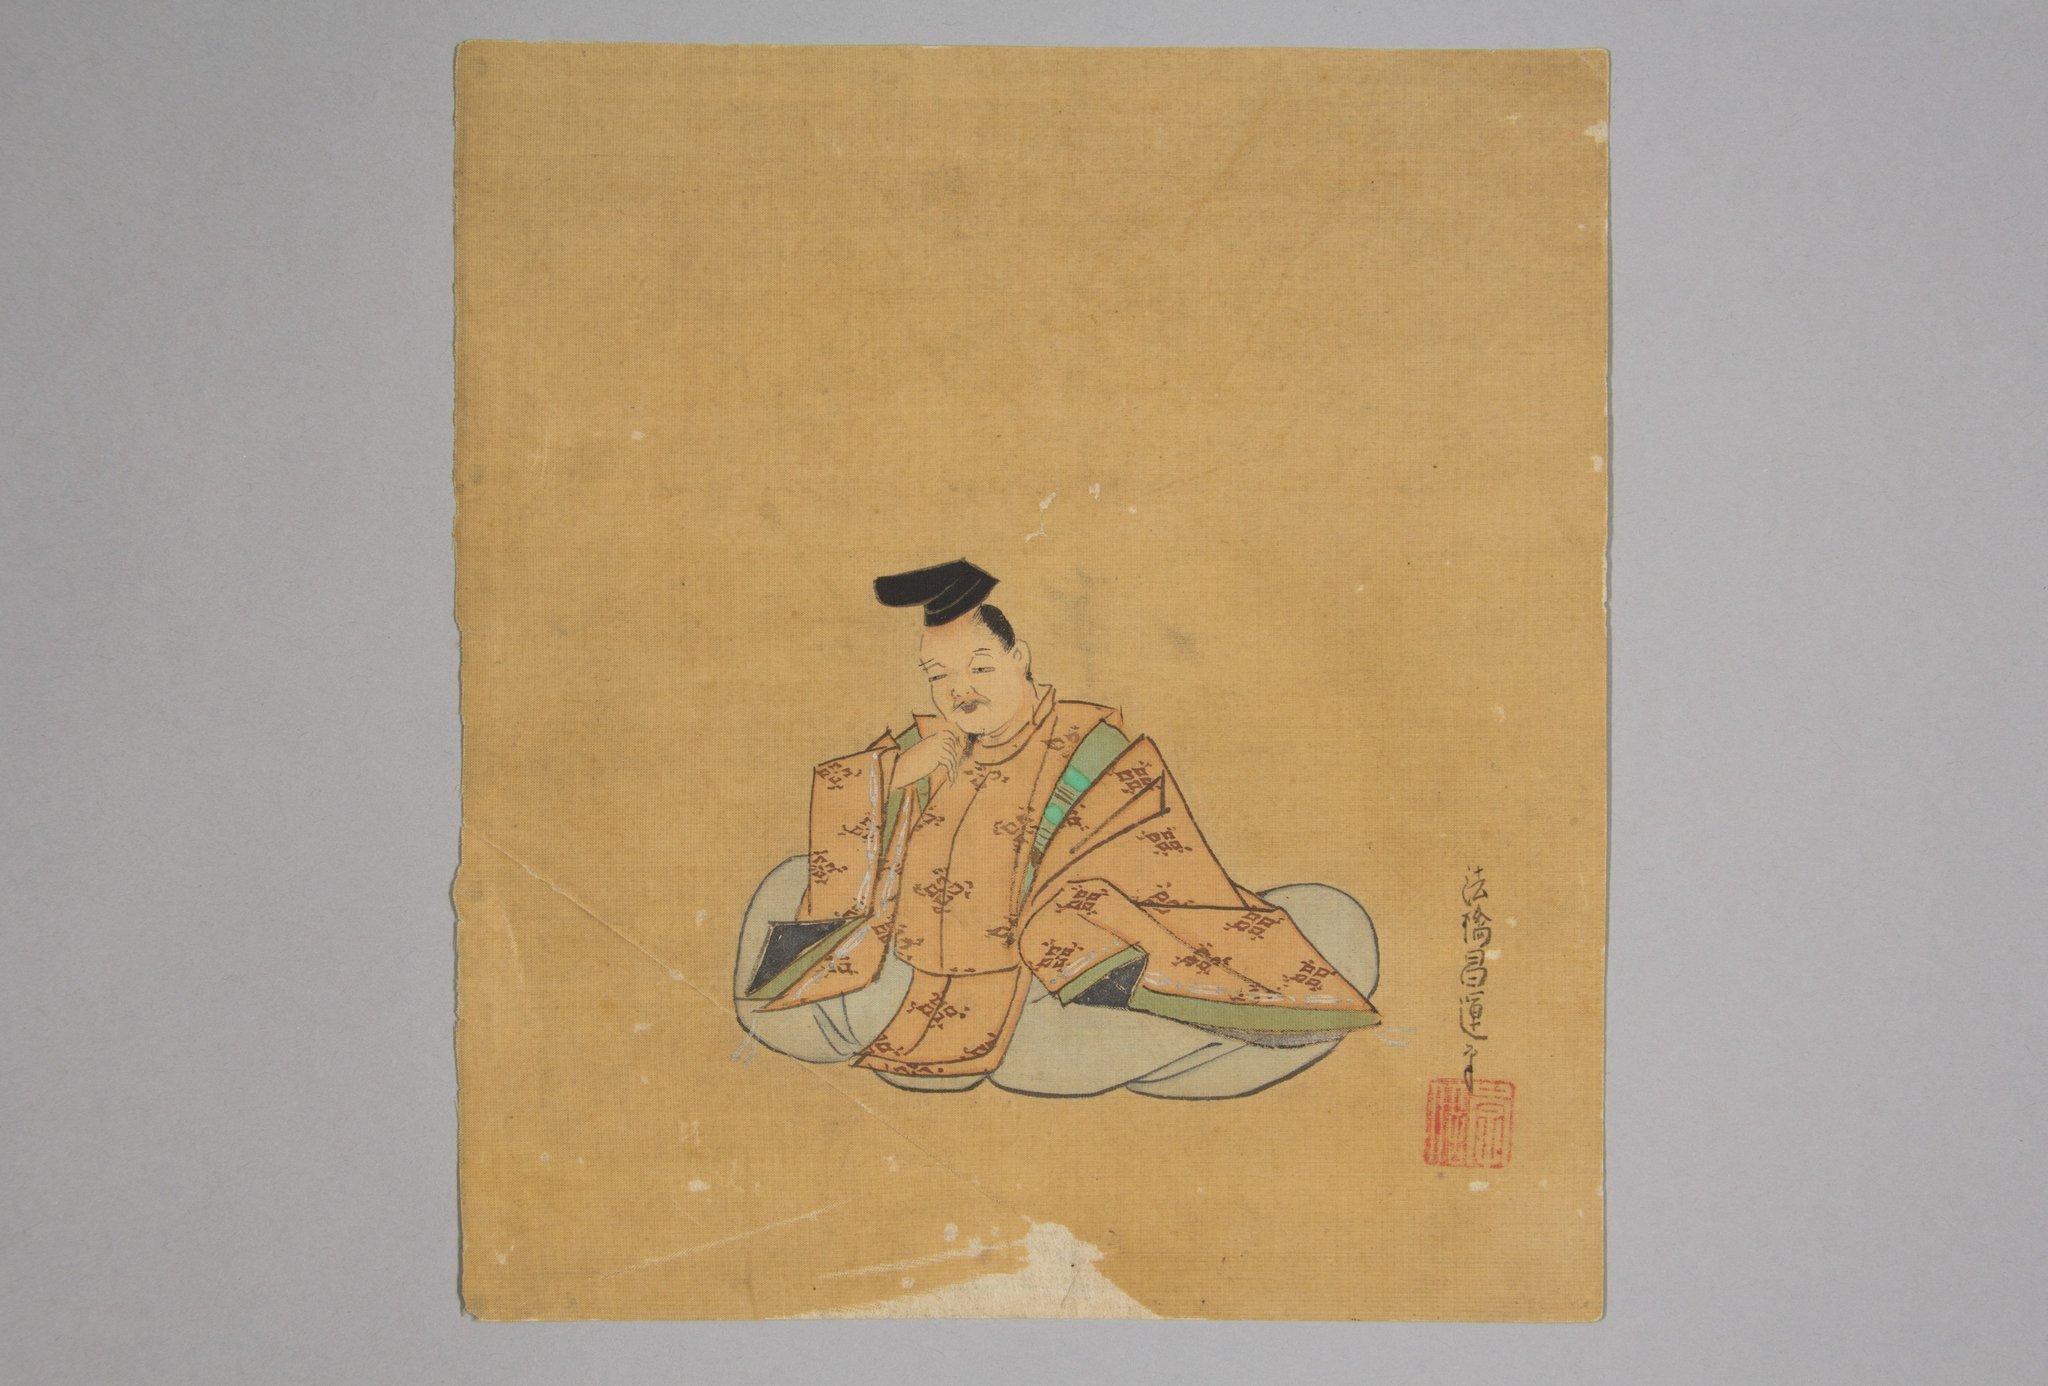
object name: painting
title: Immortal Poet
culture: japanese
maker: kano shōun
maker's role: artist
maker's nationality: japanese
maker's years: 1637-1702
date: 1601-1700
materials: ink, silk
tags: men,poets